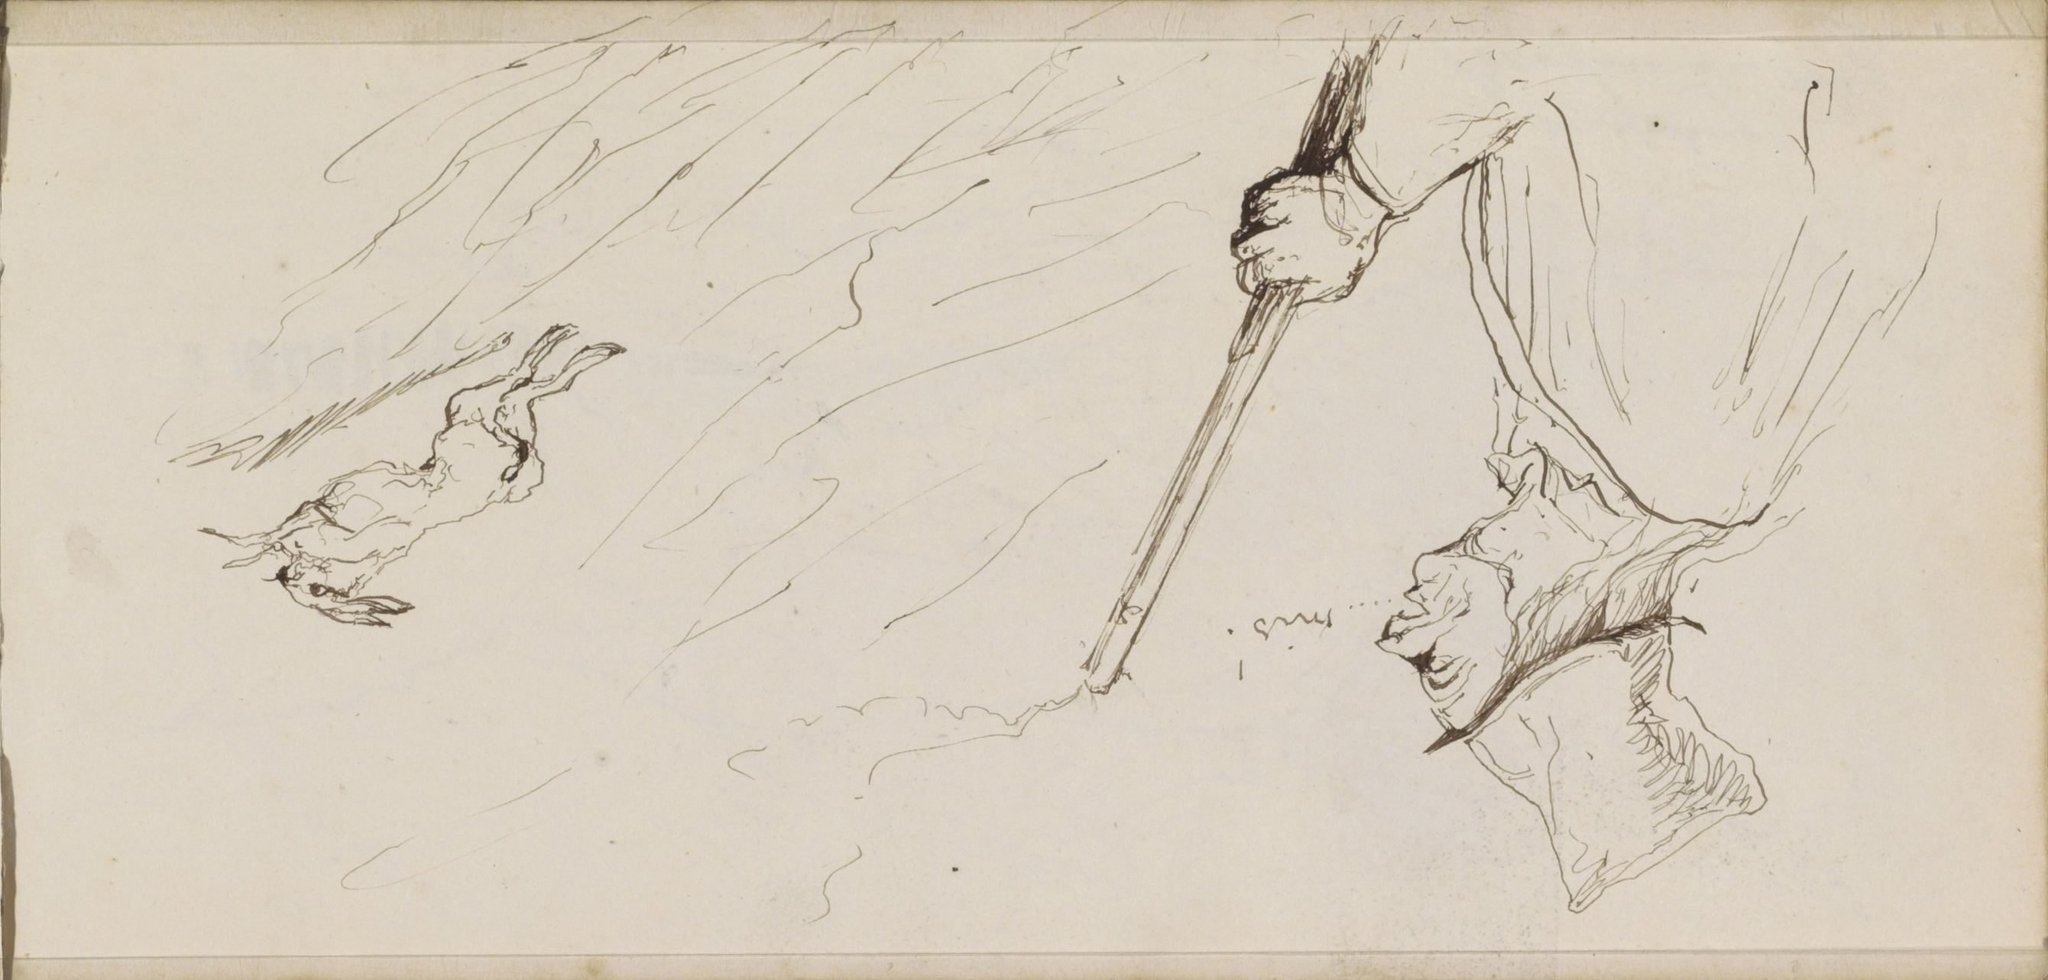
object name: sketchbook leaf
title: Karikaturale kop van een man met een hoed en stok en een haas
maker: johannes tavenraat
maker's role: draughtsman, painter, print maker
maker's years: 1809-1881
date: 1840-1868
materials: ink, paper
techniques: pen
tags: rodents: hare, adult man, head-gear: hat (+ men's clothes)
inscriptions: annotation: ‘....mis!’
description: Blad 61 recto uit een schetsboek met 63 bladen.